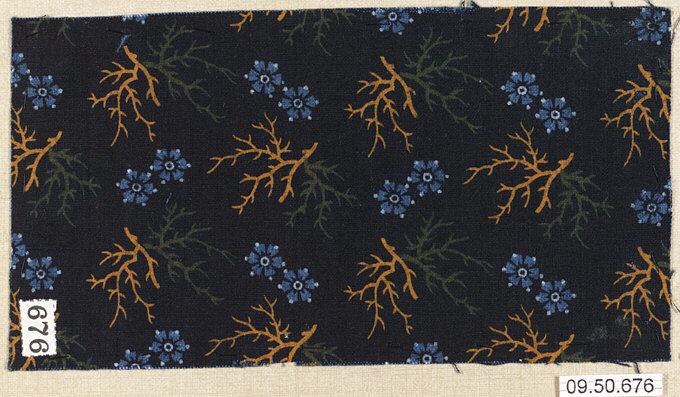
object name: piece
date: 1801-1900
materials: cotton